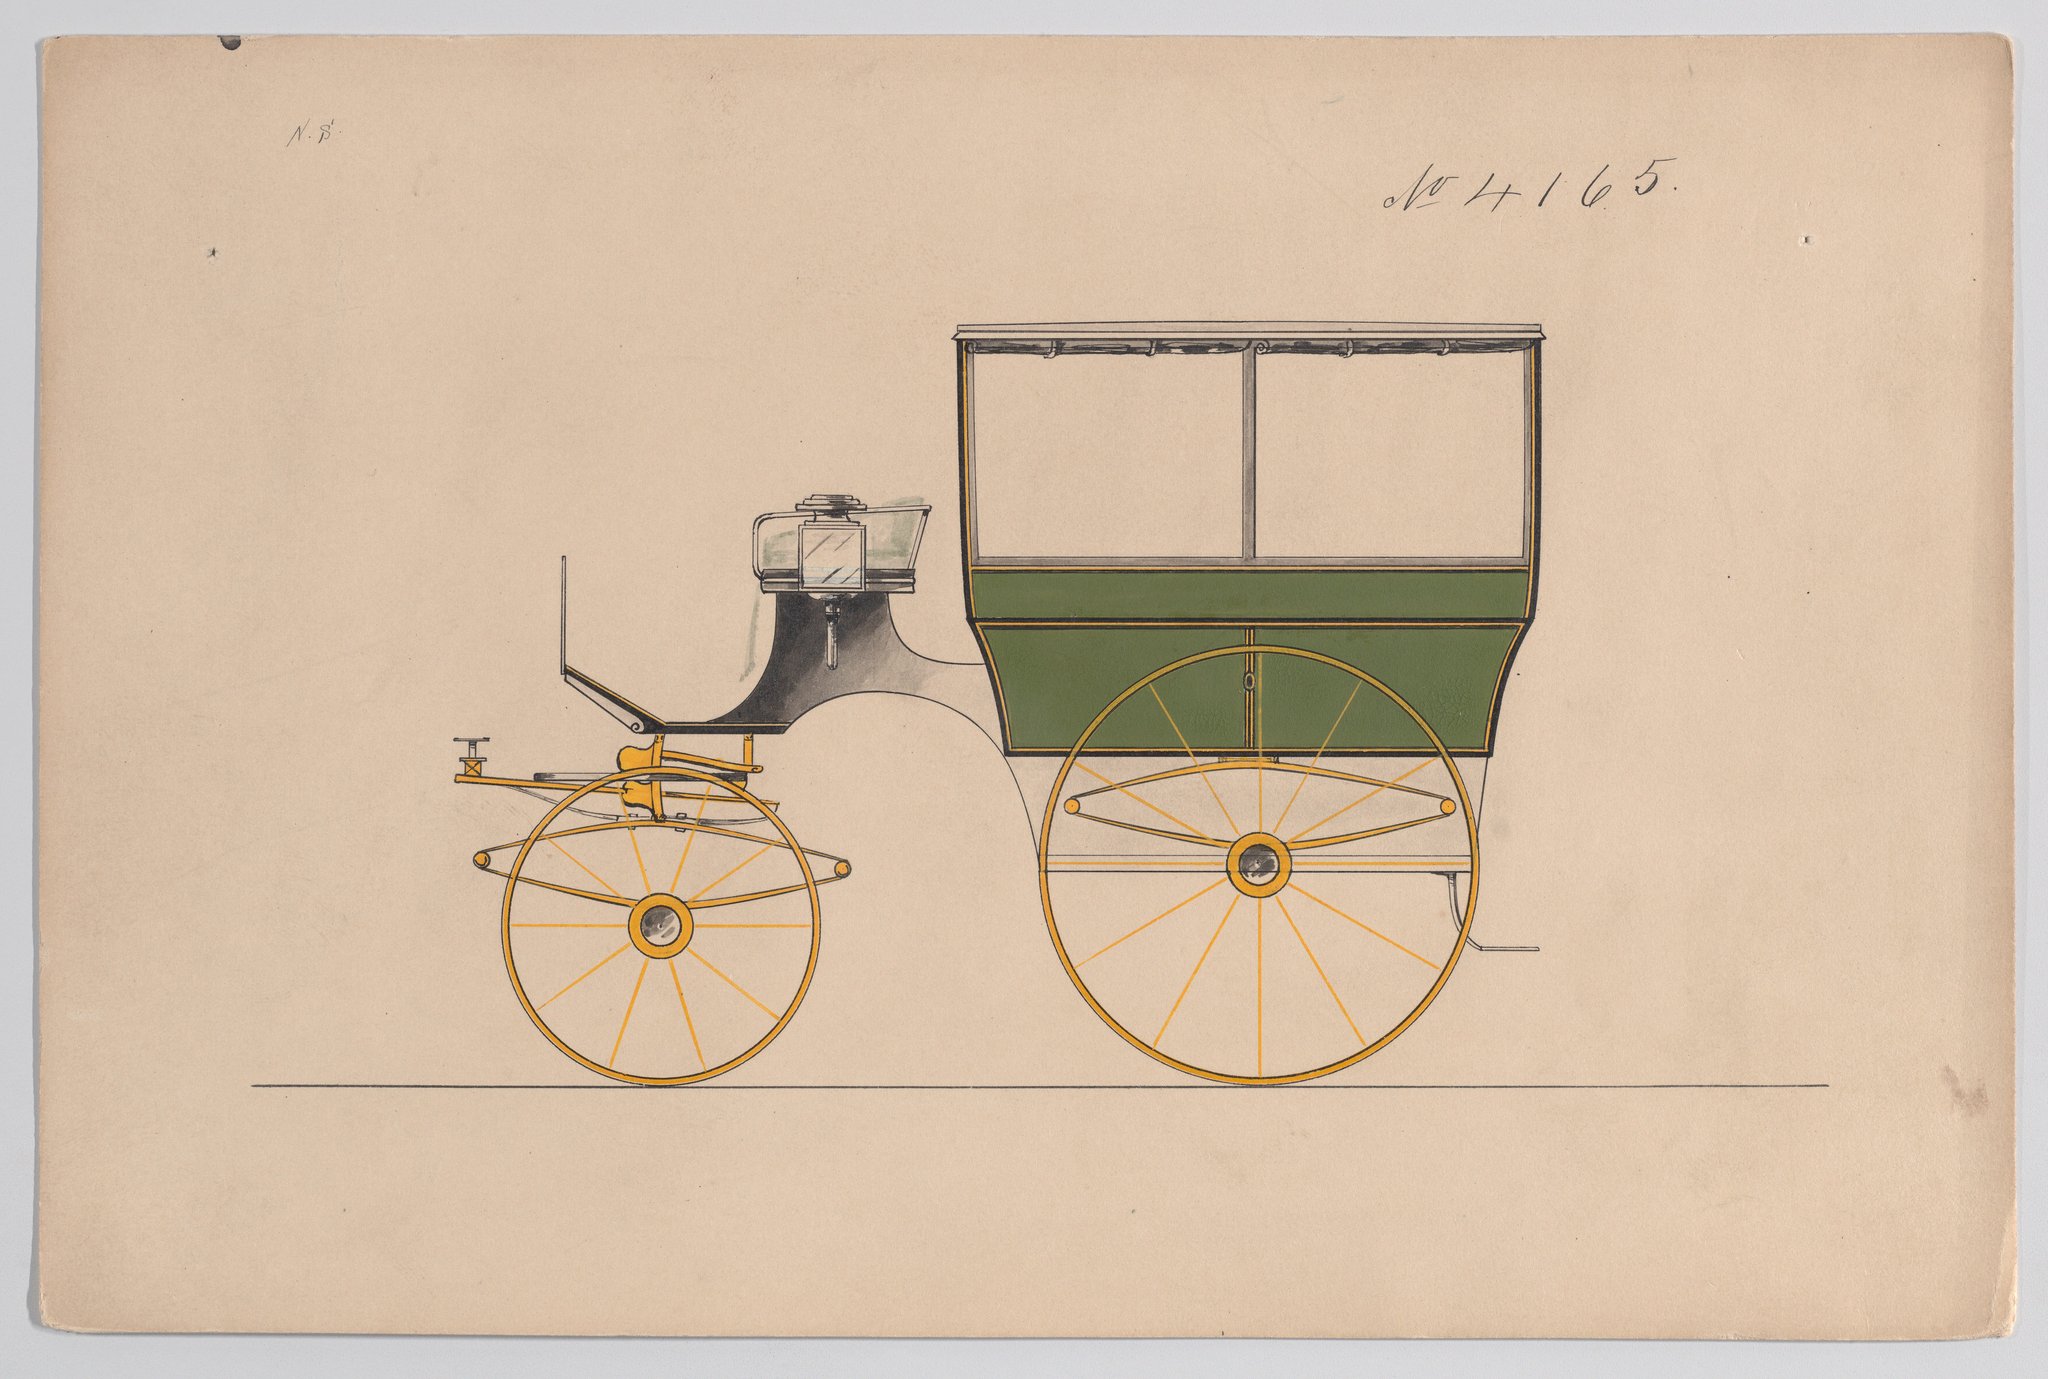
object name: drawing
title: Design for Omnibus or Wagonette, no. 4165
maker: brewster & co.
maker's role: manufacturer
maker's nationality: american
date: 1892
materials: gouache, ink, watercolor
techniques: pen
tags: carriages